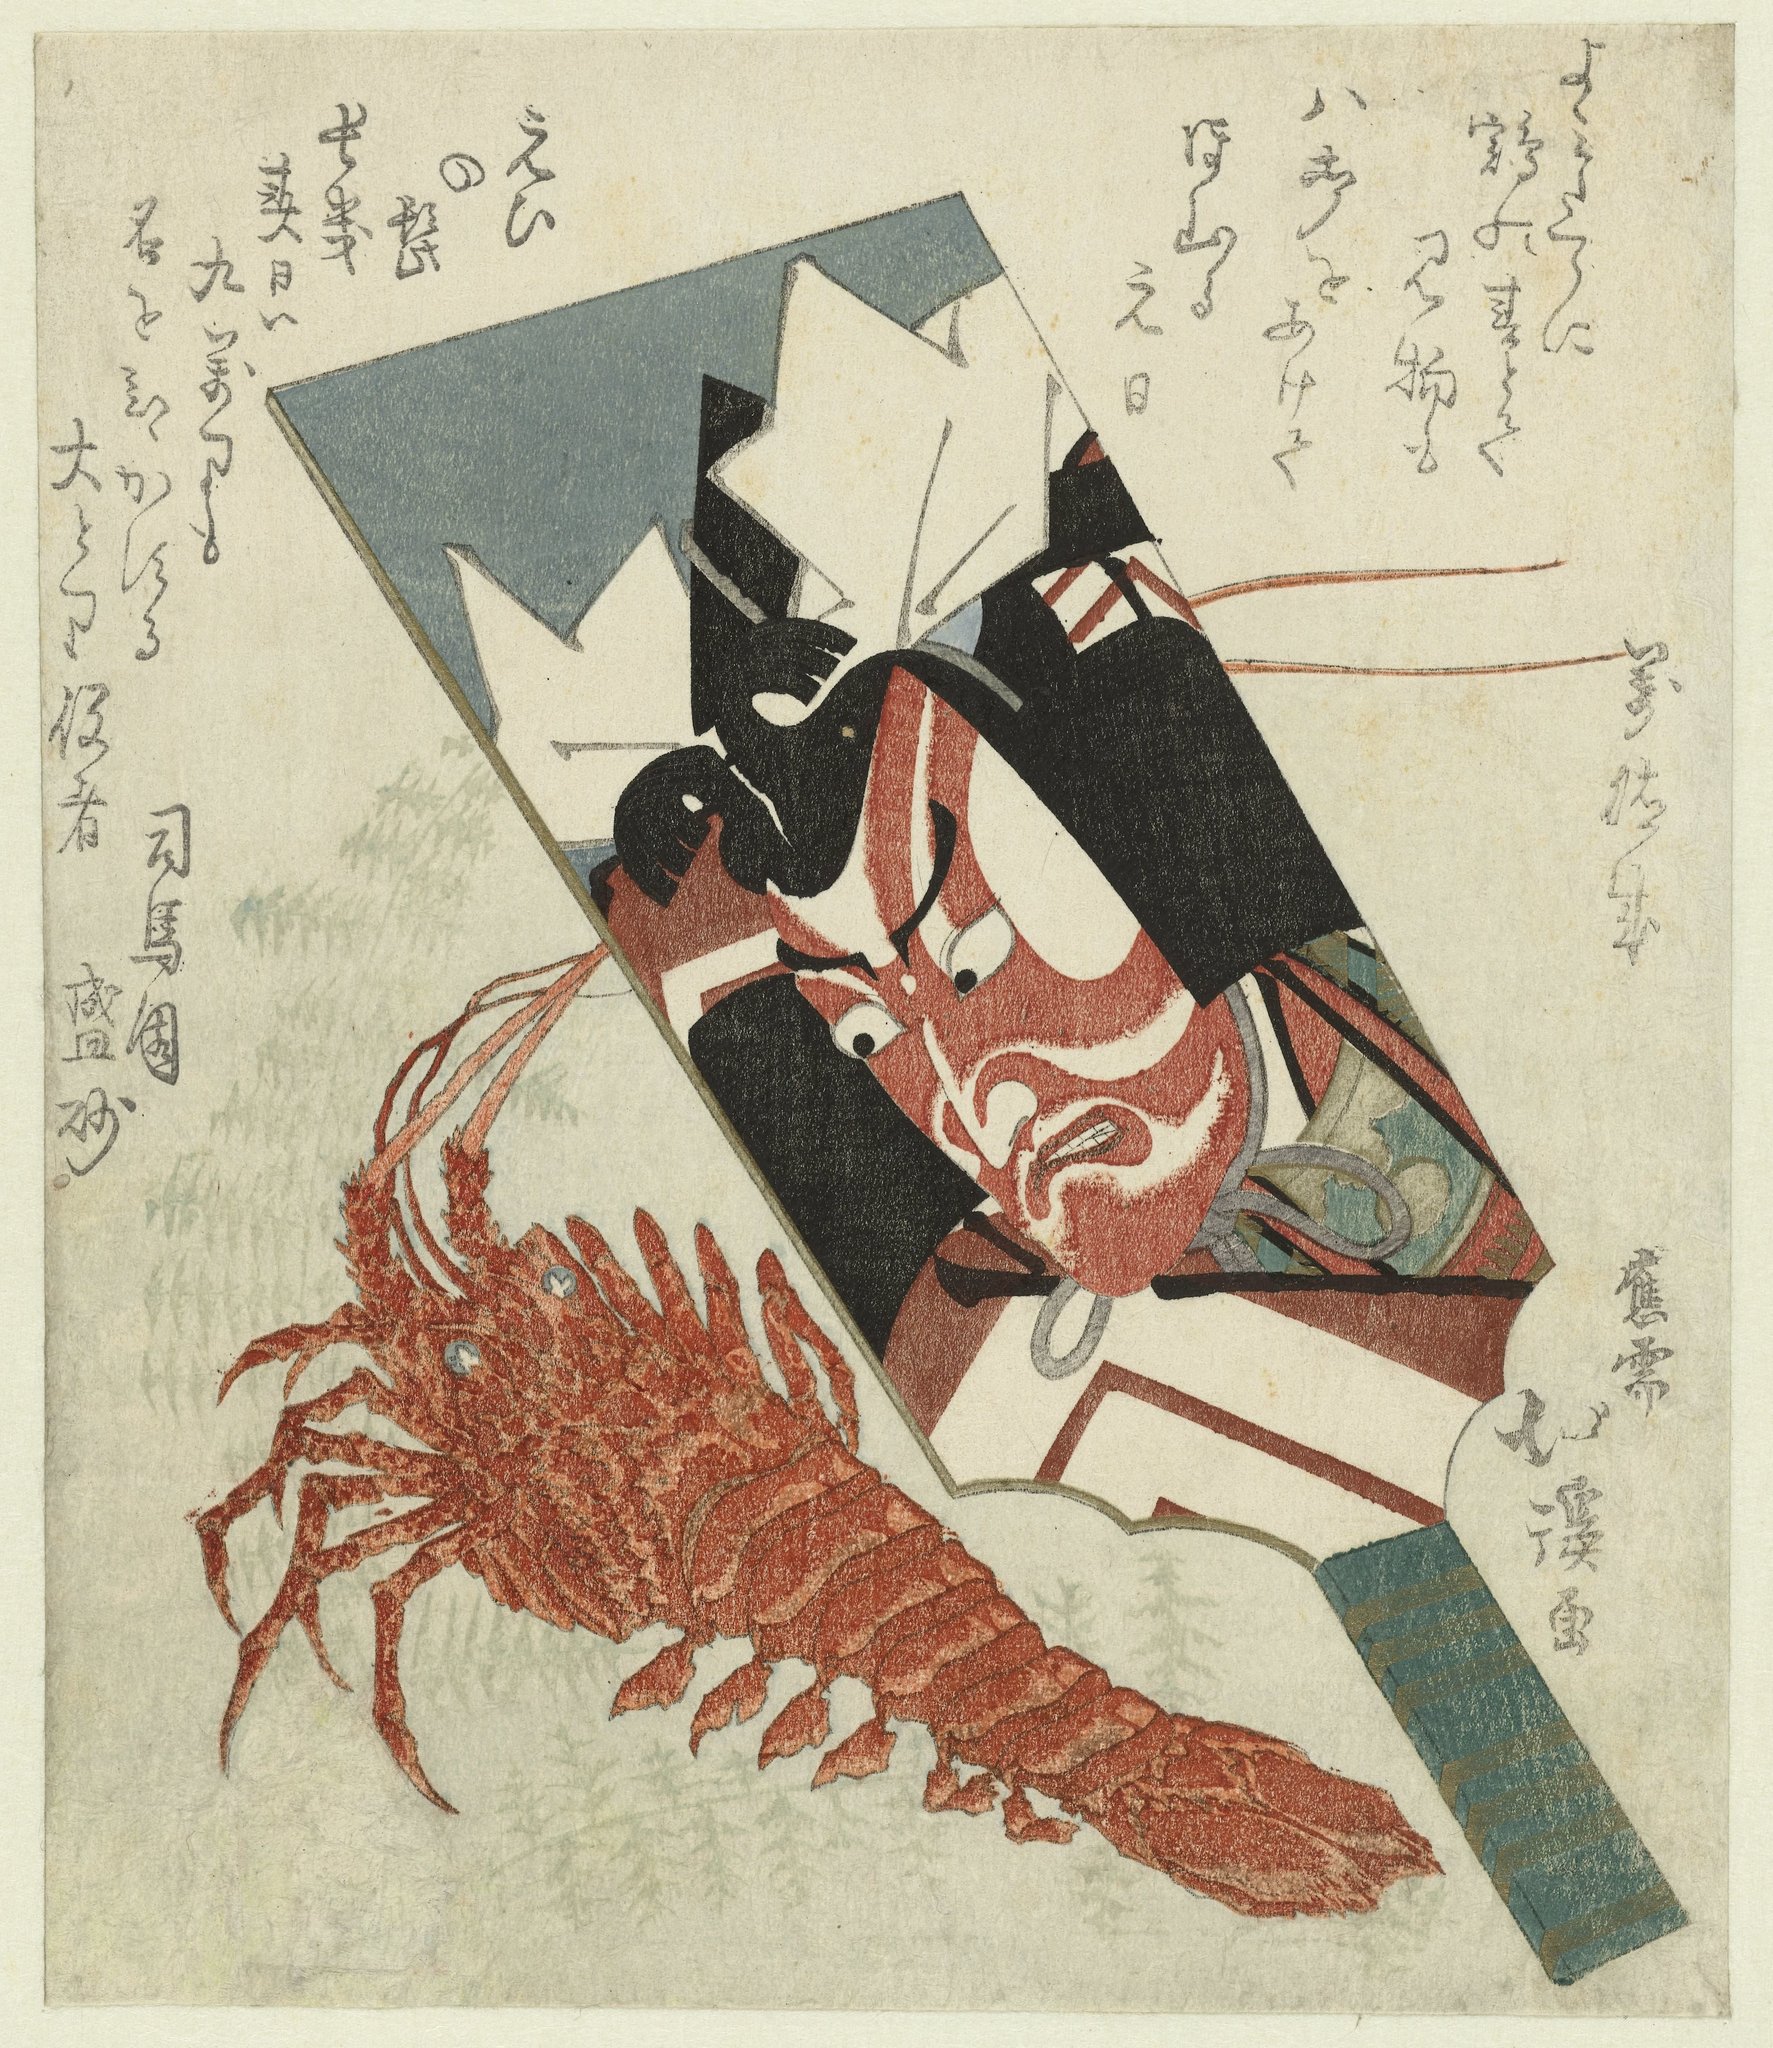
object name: surimono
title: Slaghout met portret van Ichikawa Danjûrô VII en langoustine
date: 1825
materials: paper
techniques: blind stamped, woodcut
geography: japan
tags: crustaceans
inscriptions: collector's mark, verso, stamped: Lugt 2228, collector's mark, passe-partout, bottom left, printed: JABdH with a rooster.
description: Een surimono is een luxe uitgevoerde prent waarop beeld met één of meerdere gedichten gecombineerd is. Bij het drukken van een surimono werd vaak gebruik gemaakt van dikker papier, blinddruk en metaal pigmenten, zoals koper- en zilverpoeder. De prenten werden vaak in opdracht van dichters gemaakt en als exclusief geschenk aan vrienden en relaties gegeven.